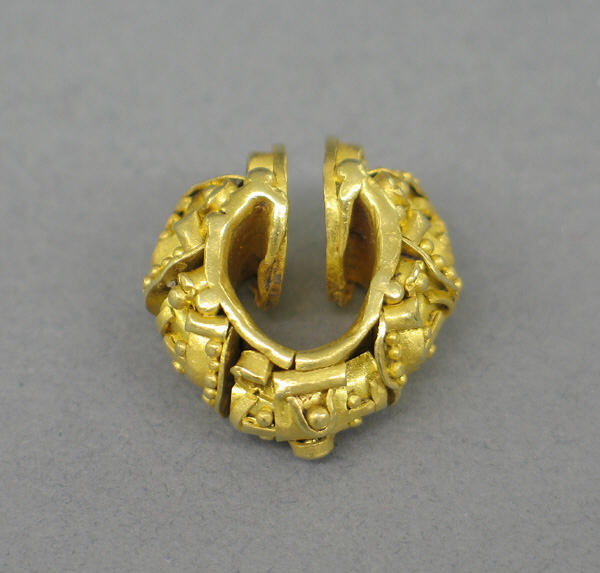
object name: ear ornament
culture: indonesian, javanese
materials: gold